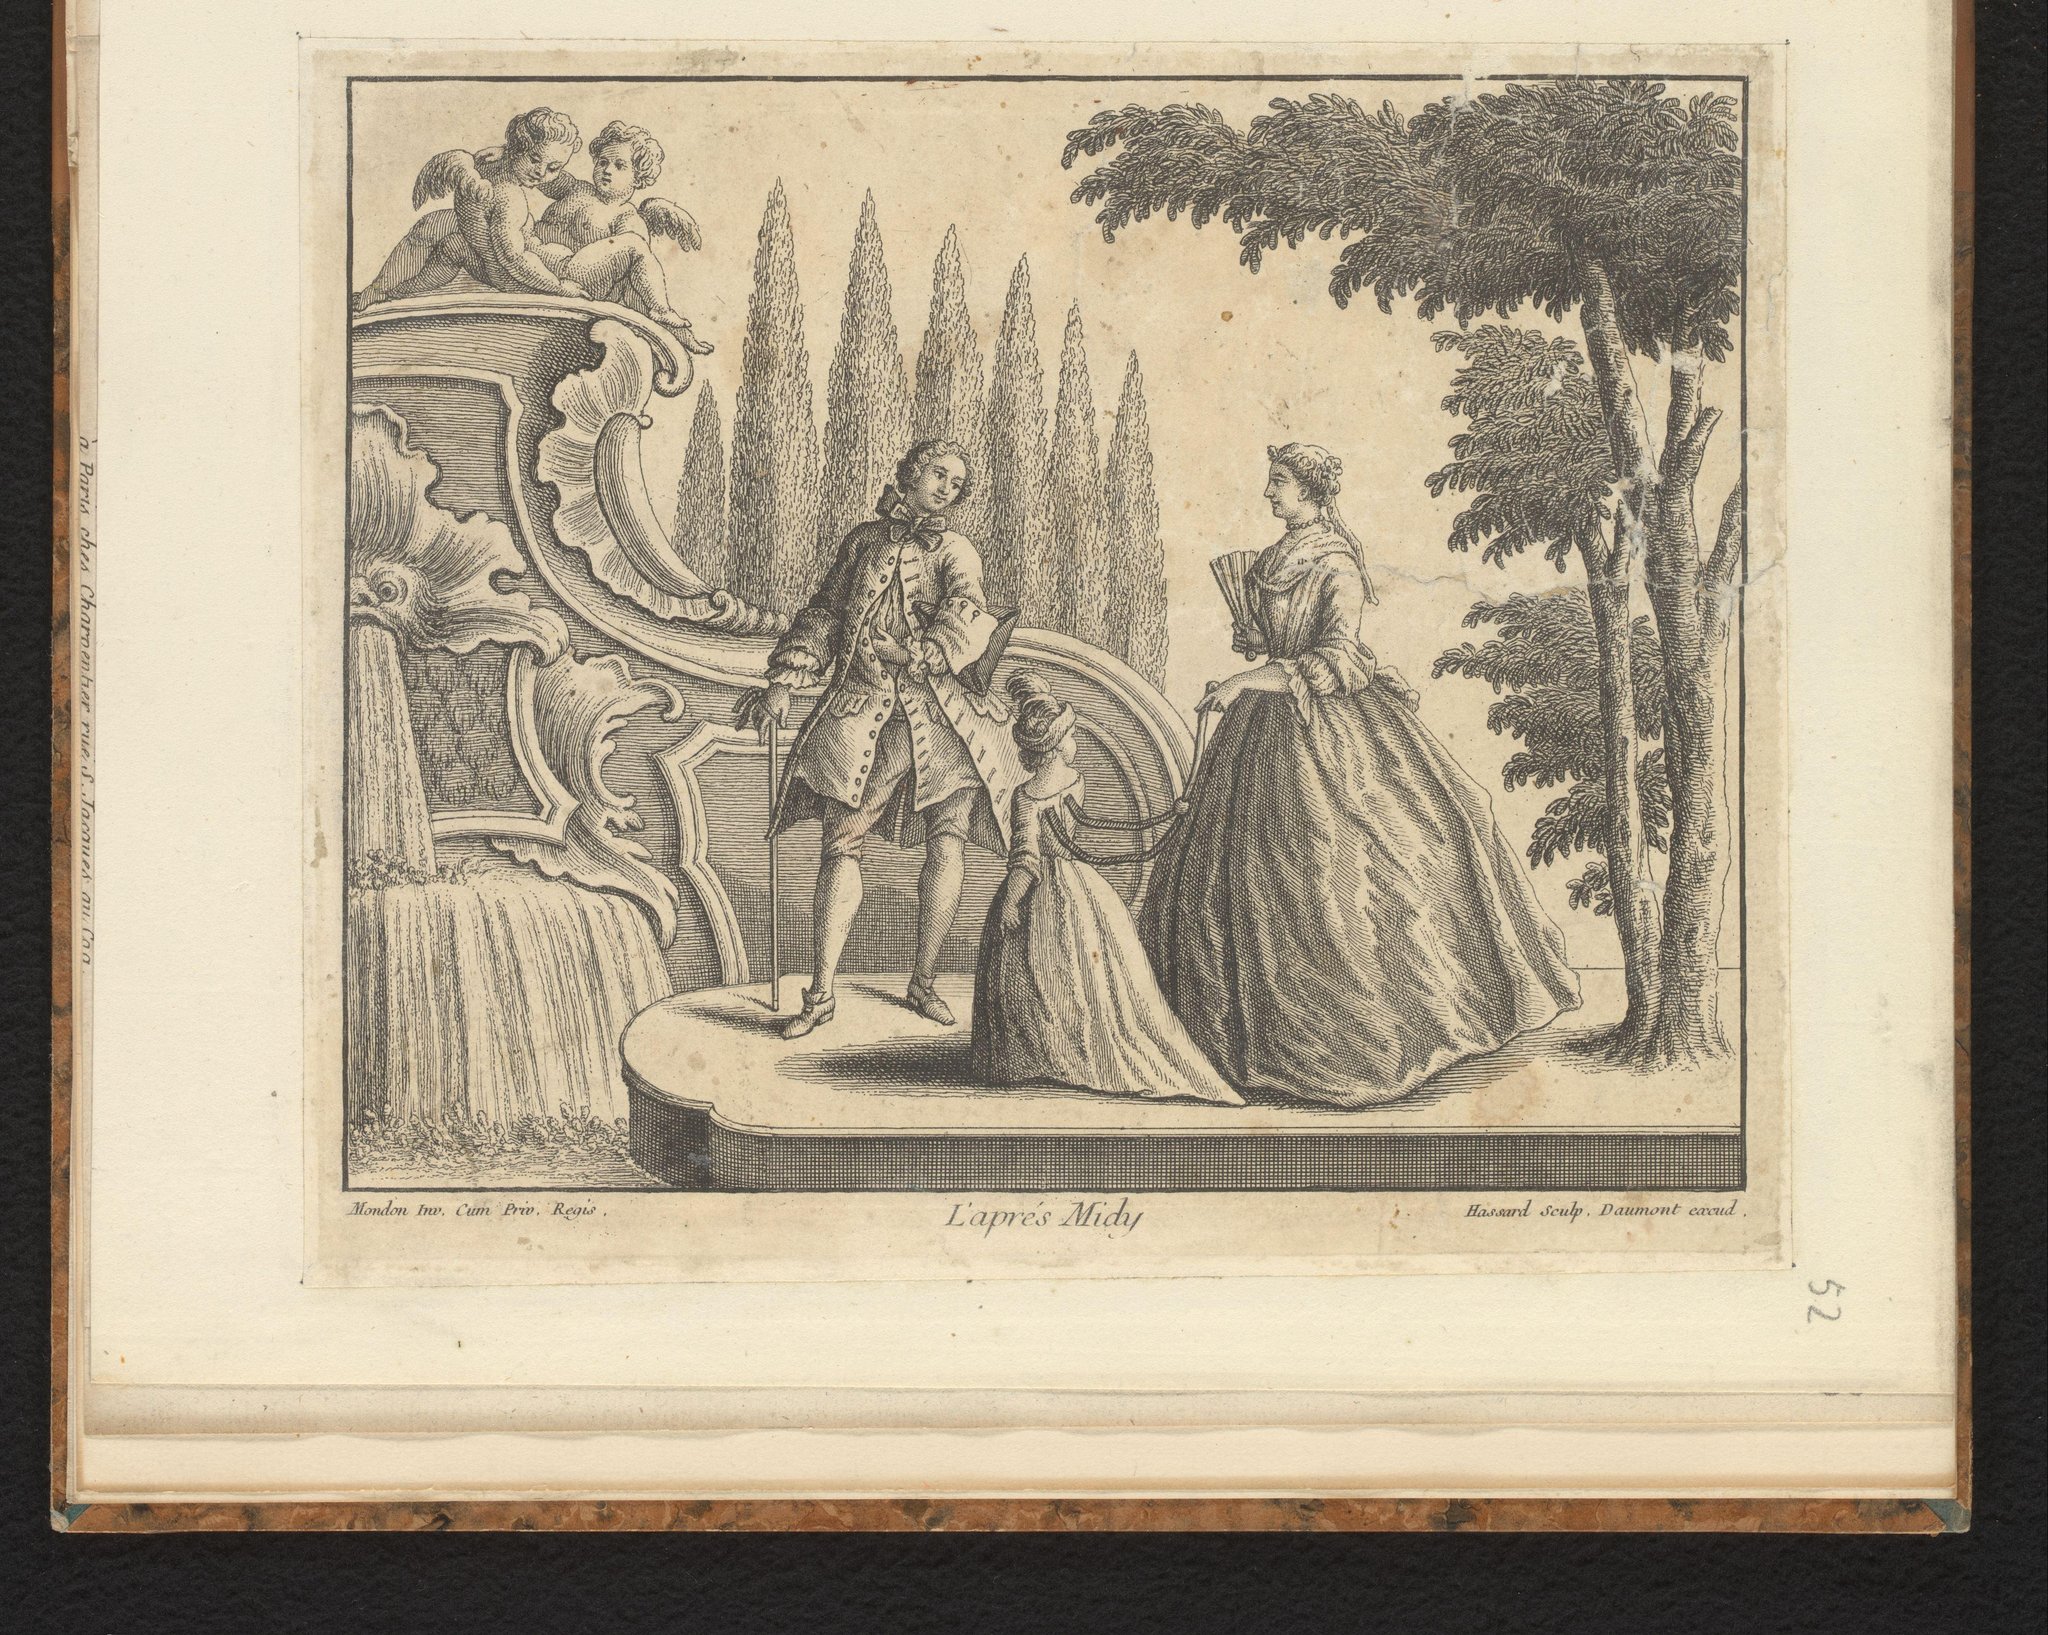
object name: ornament print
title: L'aprés Midy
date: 1719-1775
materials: paper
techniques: etching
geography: paris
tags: rocaille ornament, garden fountain